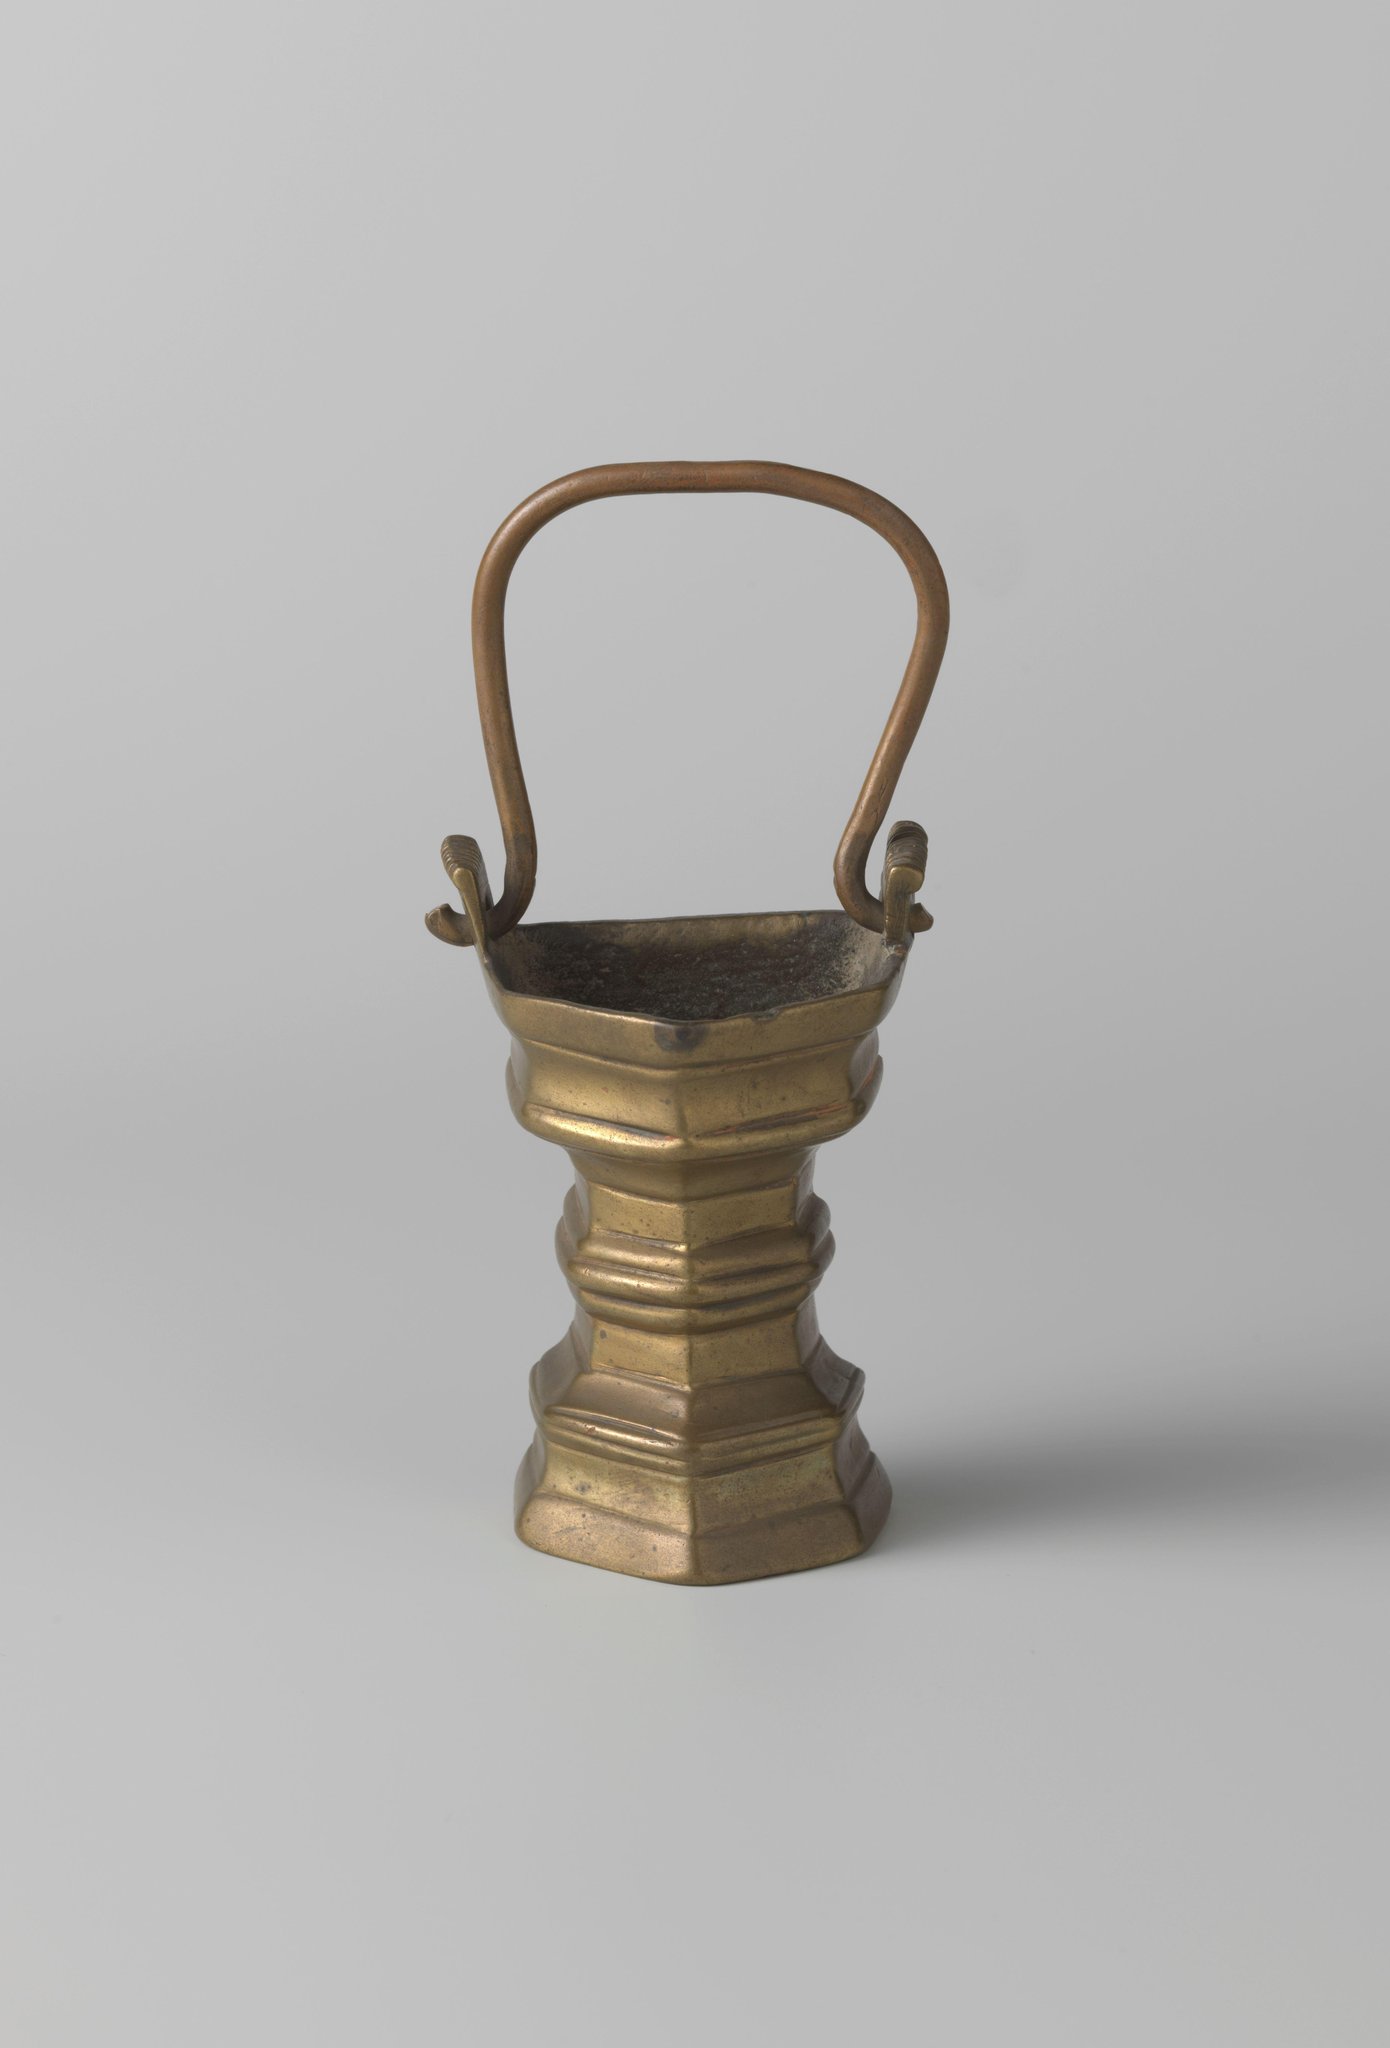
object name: aspersorium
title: Wijwateremmer, vijfzijdig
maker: Anonymous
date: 1475-1525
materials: brass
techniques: casting, metalworking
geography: southern netherlands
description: De vijfzijdige emmer met de aanzetstukken is gegoten. Vier zijden hebben een aan de architectuur ontleende profilering. De vijfde is glad en vormt de achterkant. De emmer kraagt uit naar de bovenrand toe en bij de holle voet. Twee zijden hebben een aanzetstuk, waarvan de rechte bovenkant door ciselering is gekarteld. In deze stukken is het vernieuwde hengsel bevestigd. Eén aanzetstuk is hersteld.